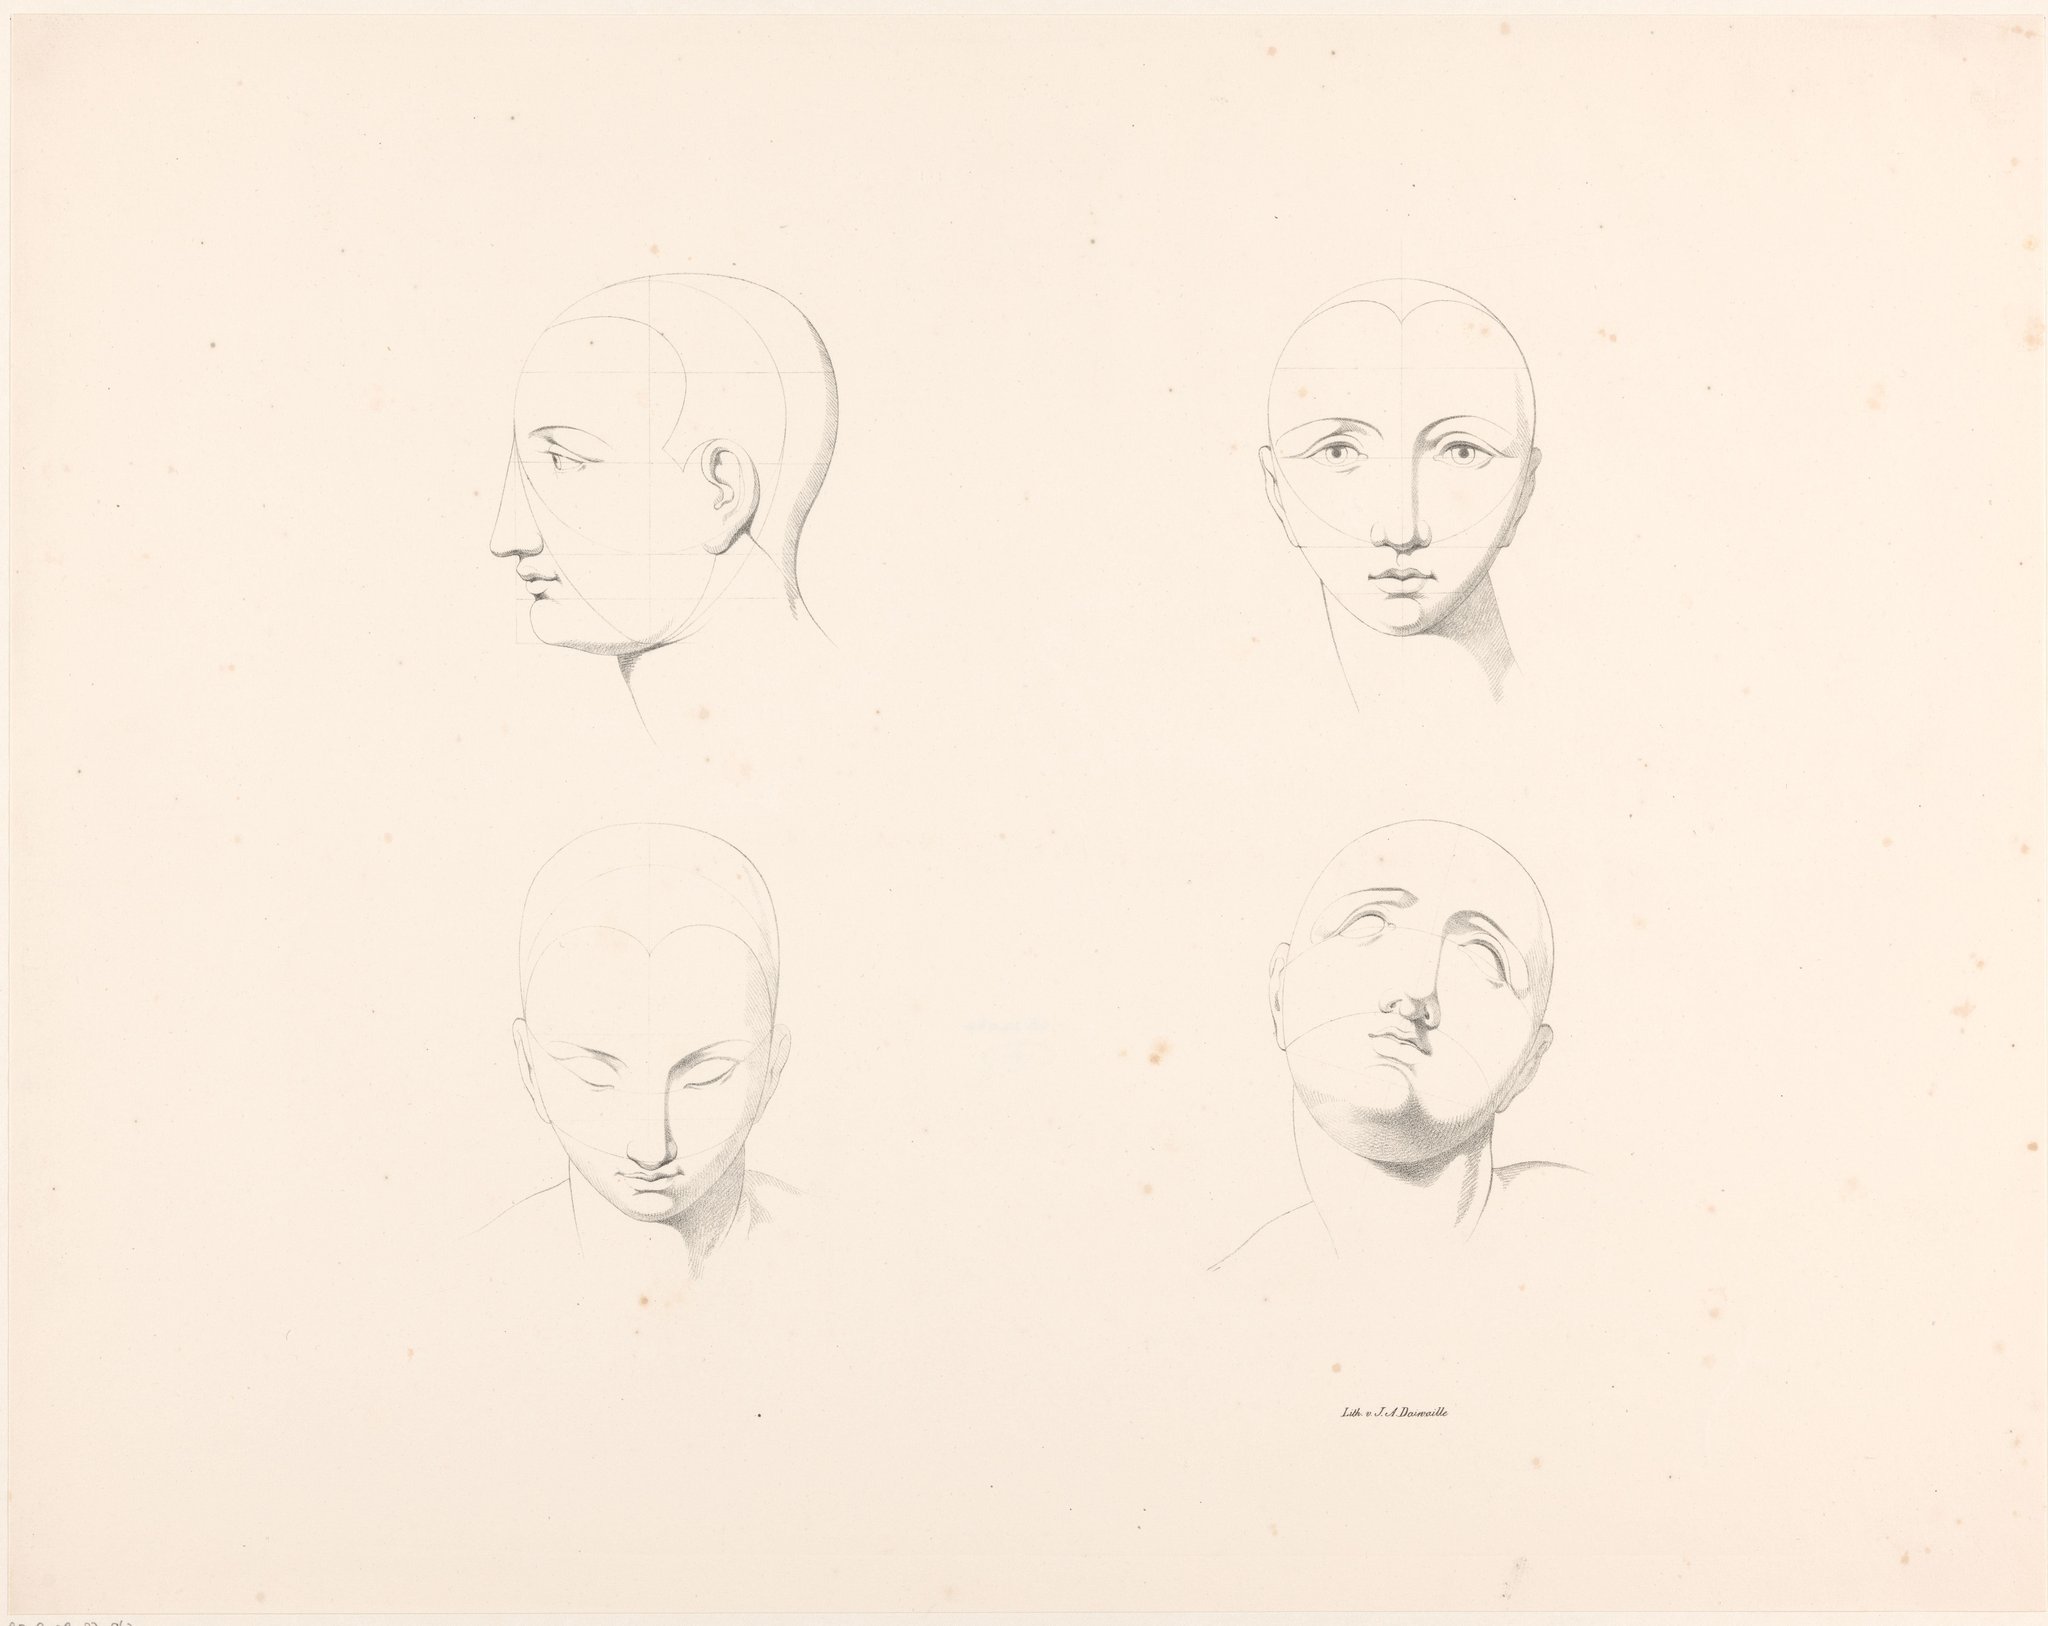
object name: print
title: Vier standen van het hoofd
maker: jean augustin daiwaille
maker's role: draughtsman, print maker, printer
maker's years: 1786-1850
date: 1820-1833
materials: paper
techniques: lithograph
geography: amsterdam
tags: head (human) (+ front view), head (human) (+ sideview, profile)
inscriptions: collector's mark: Lugt 2228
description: Door het hoofd zijn lijnen gestrokken. Het hoofd linksboven kijkt naar links, het hoofd rechtsboven kijkt de beschouwer frontaal aan. Het hoofd linksonder kijkt naar beneden, het hoofd daarnaast is naar boven weggedraaid.